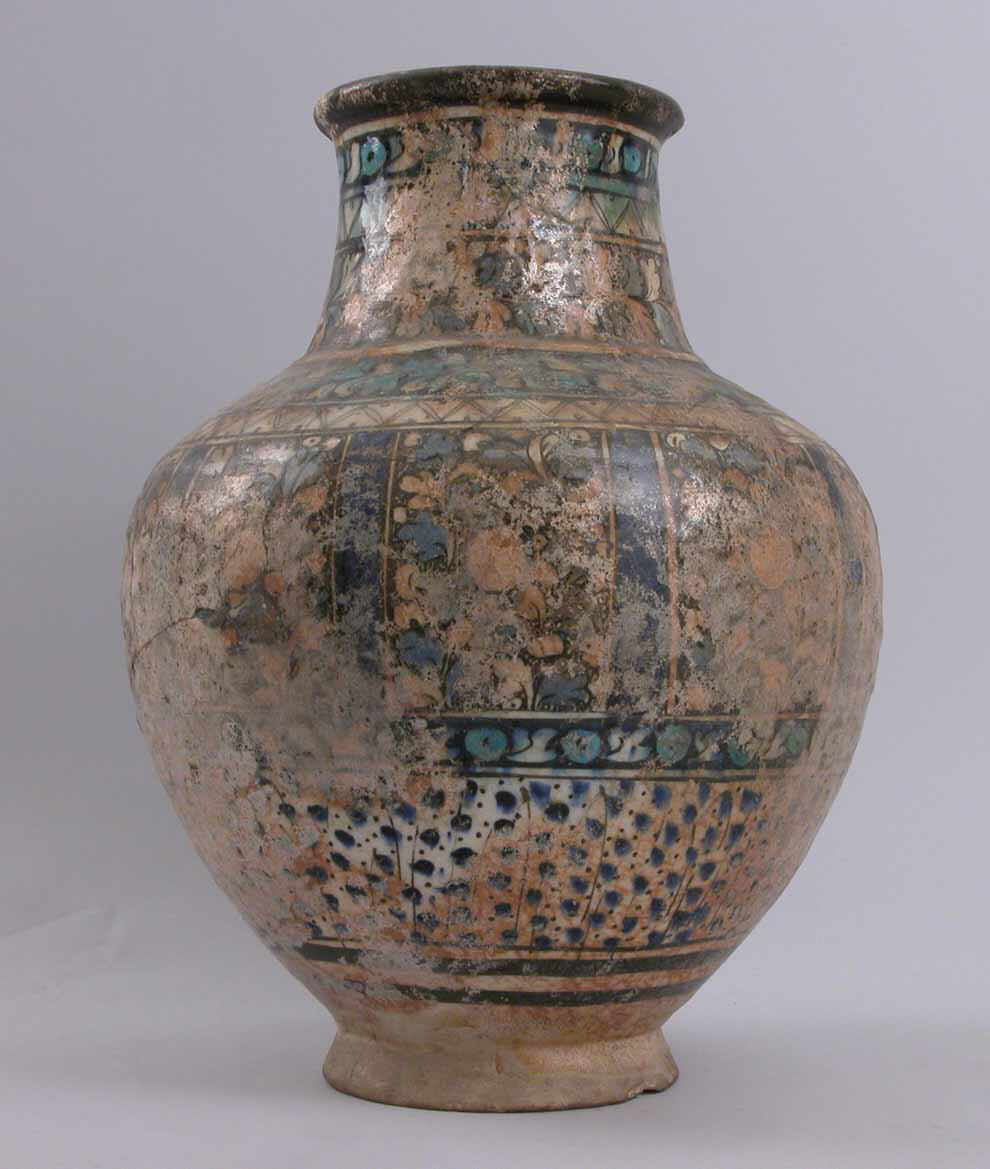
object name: jar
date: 1301-1400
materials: stonepaste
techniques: painting, underglaze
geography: iran